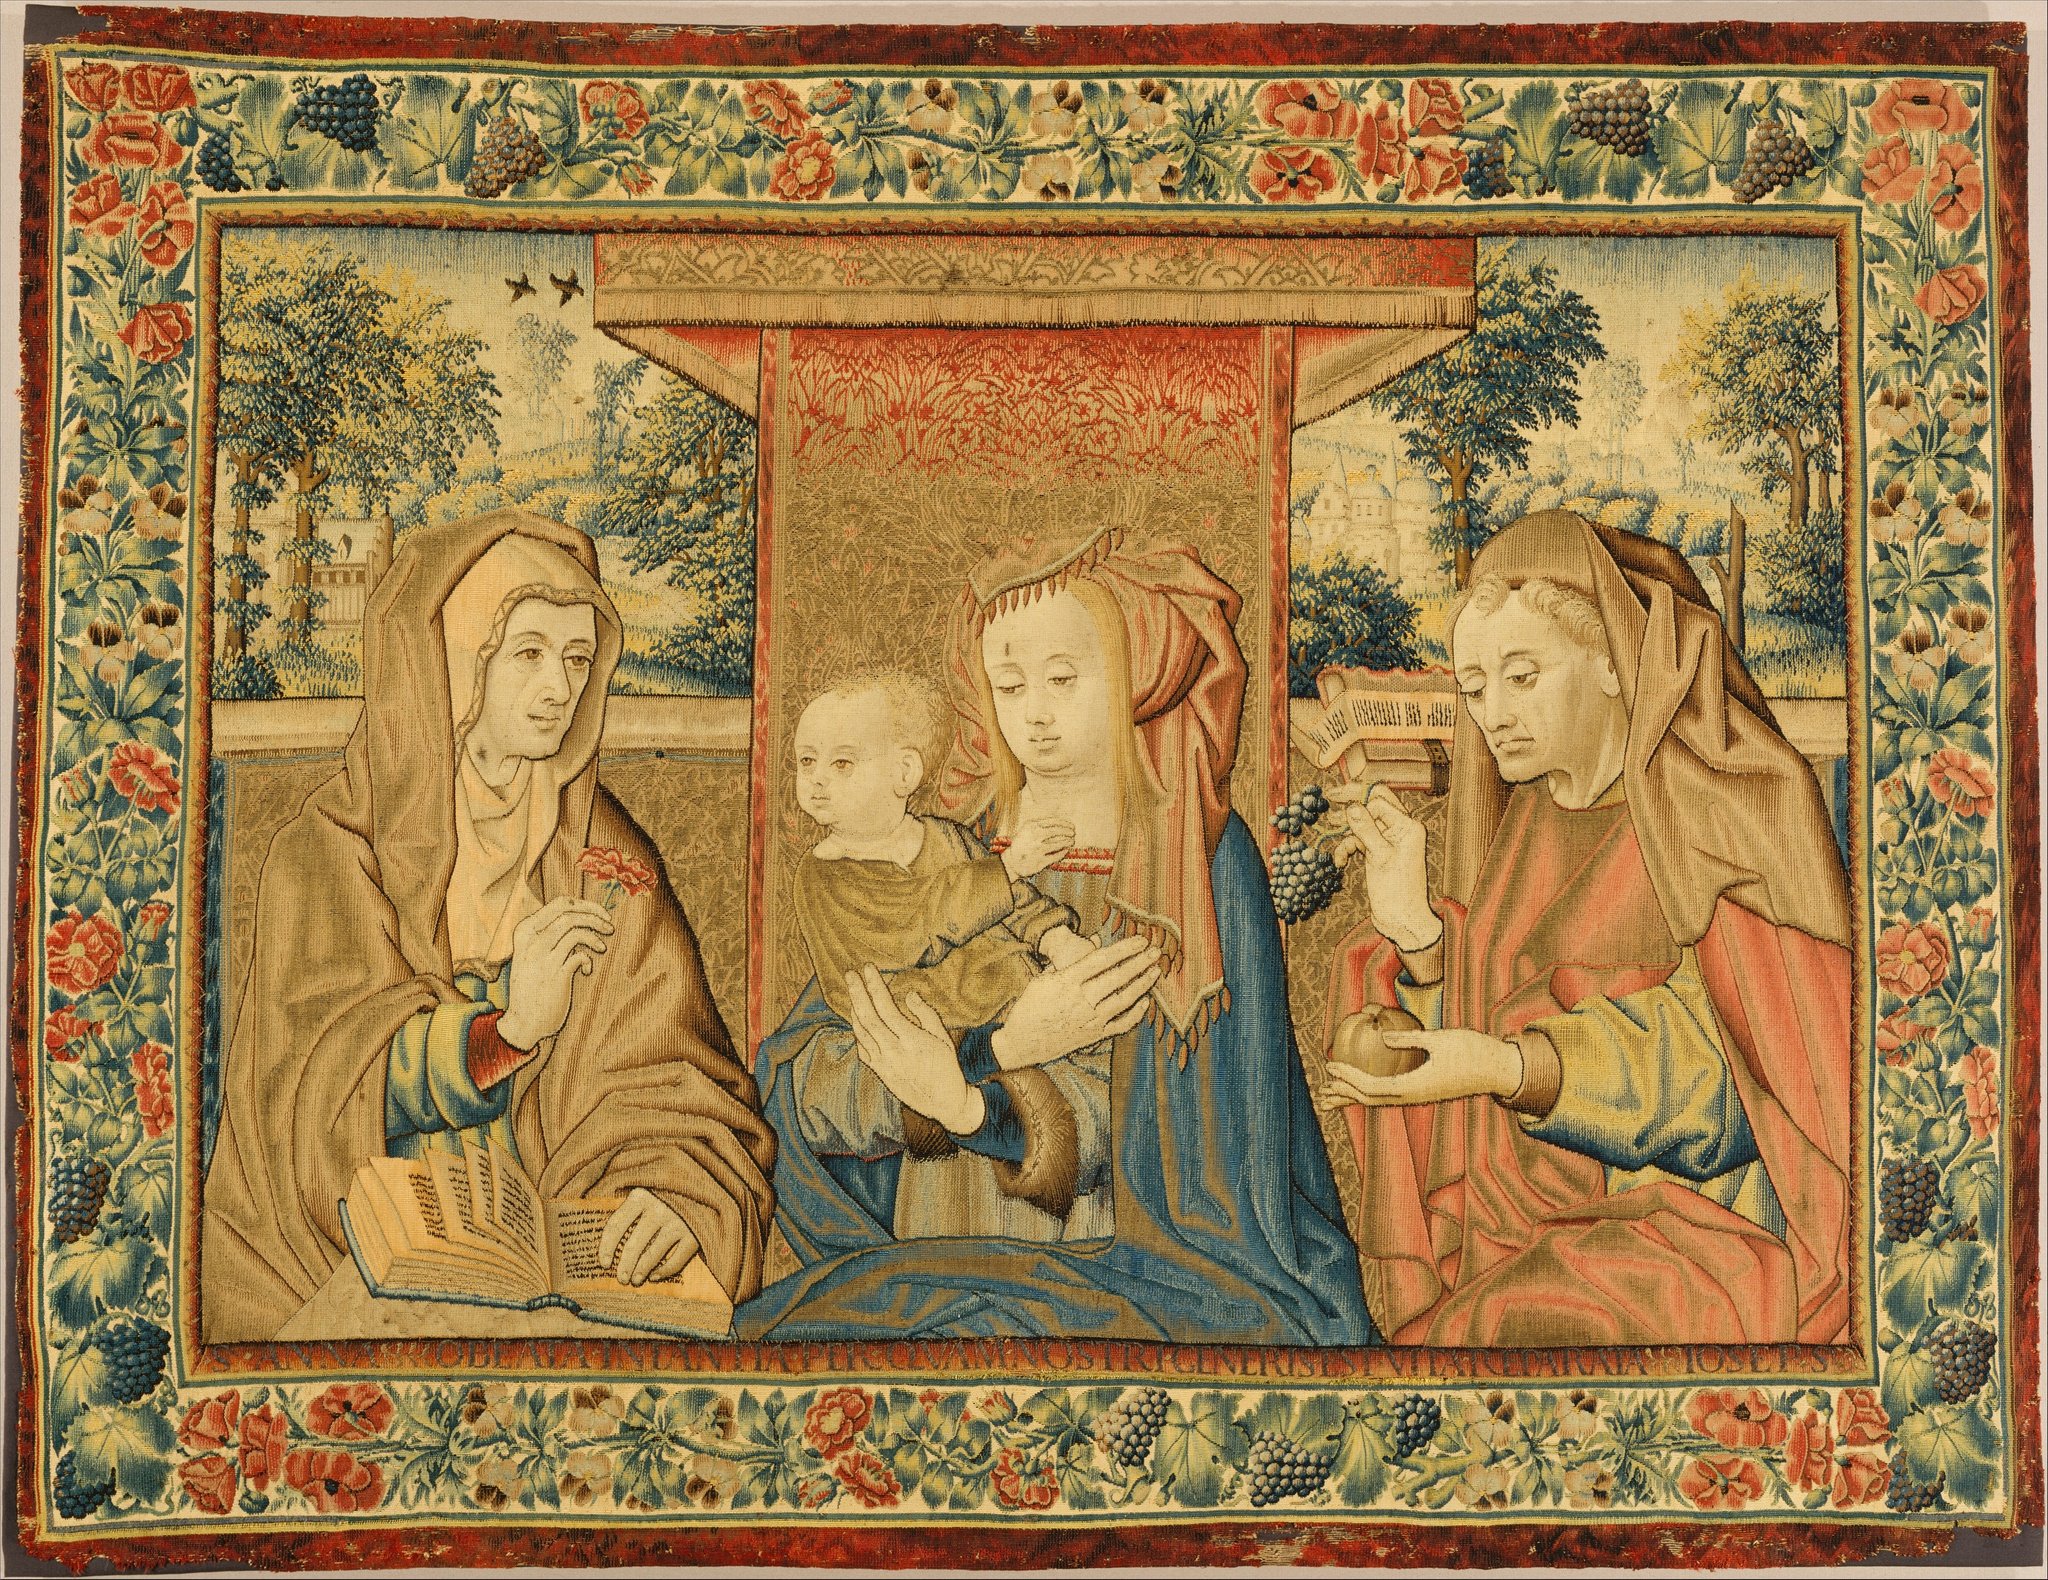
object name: tapestry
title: The Holy Family with Saint Anne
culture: south netherlandish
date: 1500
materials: gilt, linen, silk, silver, wool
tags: saint anne,saint joseph,virgin mary,jesus